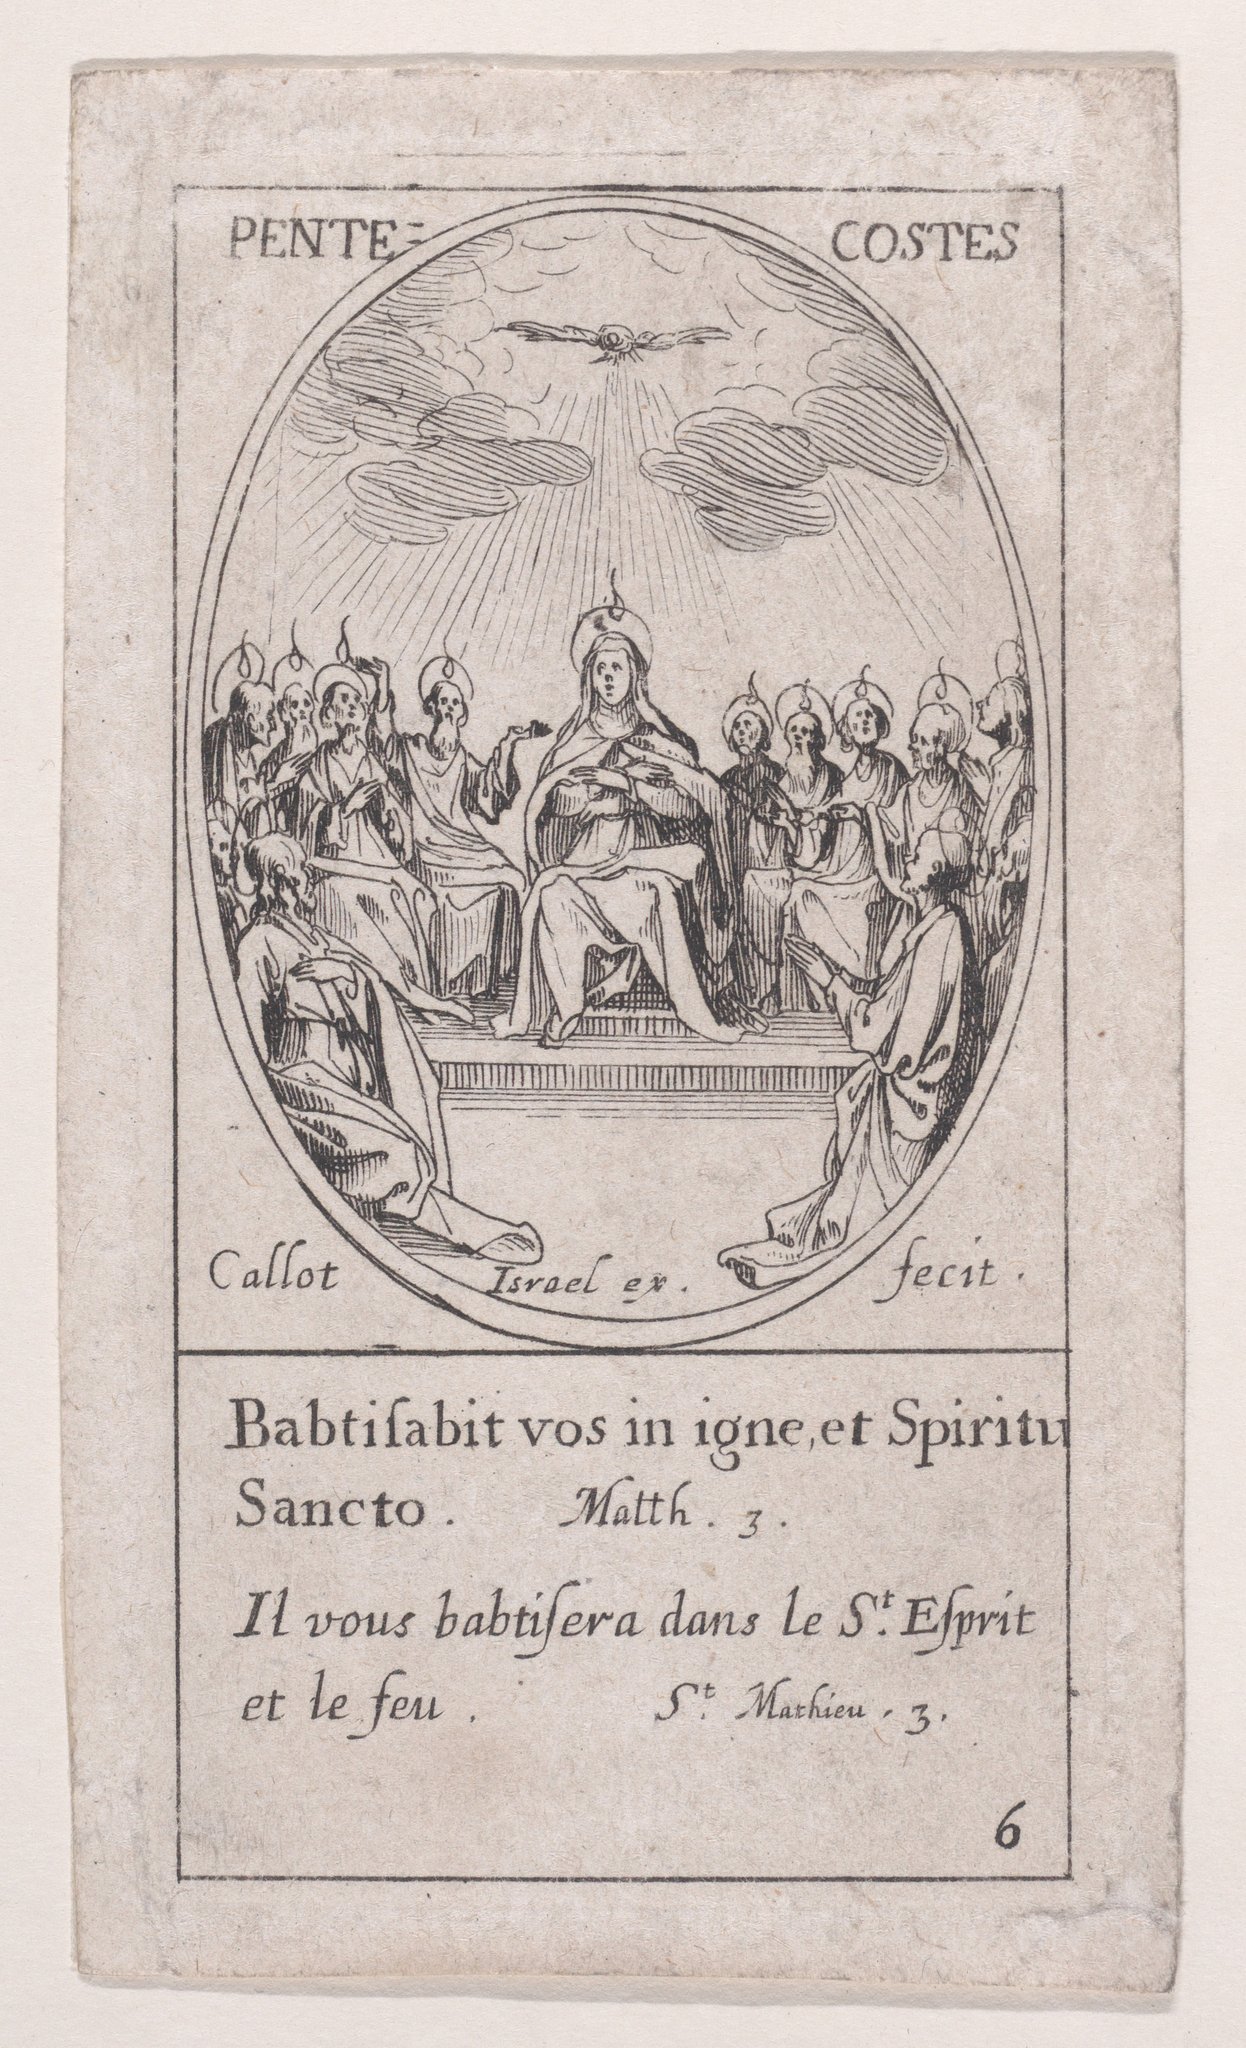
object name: print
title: La Pentecôte (The Pentecost), scene 6 from Images des Fêtes Mobiles (Images of Moveable Feasts from the Christian Calendar), part of "Les Images De Tous Les Saincts et Saintes de L'Année" (Images of All of the Saints and Religious Events of the Year)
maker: jacques callot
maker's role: artist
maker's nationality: french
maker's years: 1592-1635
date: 1632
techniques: etching